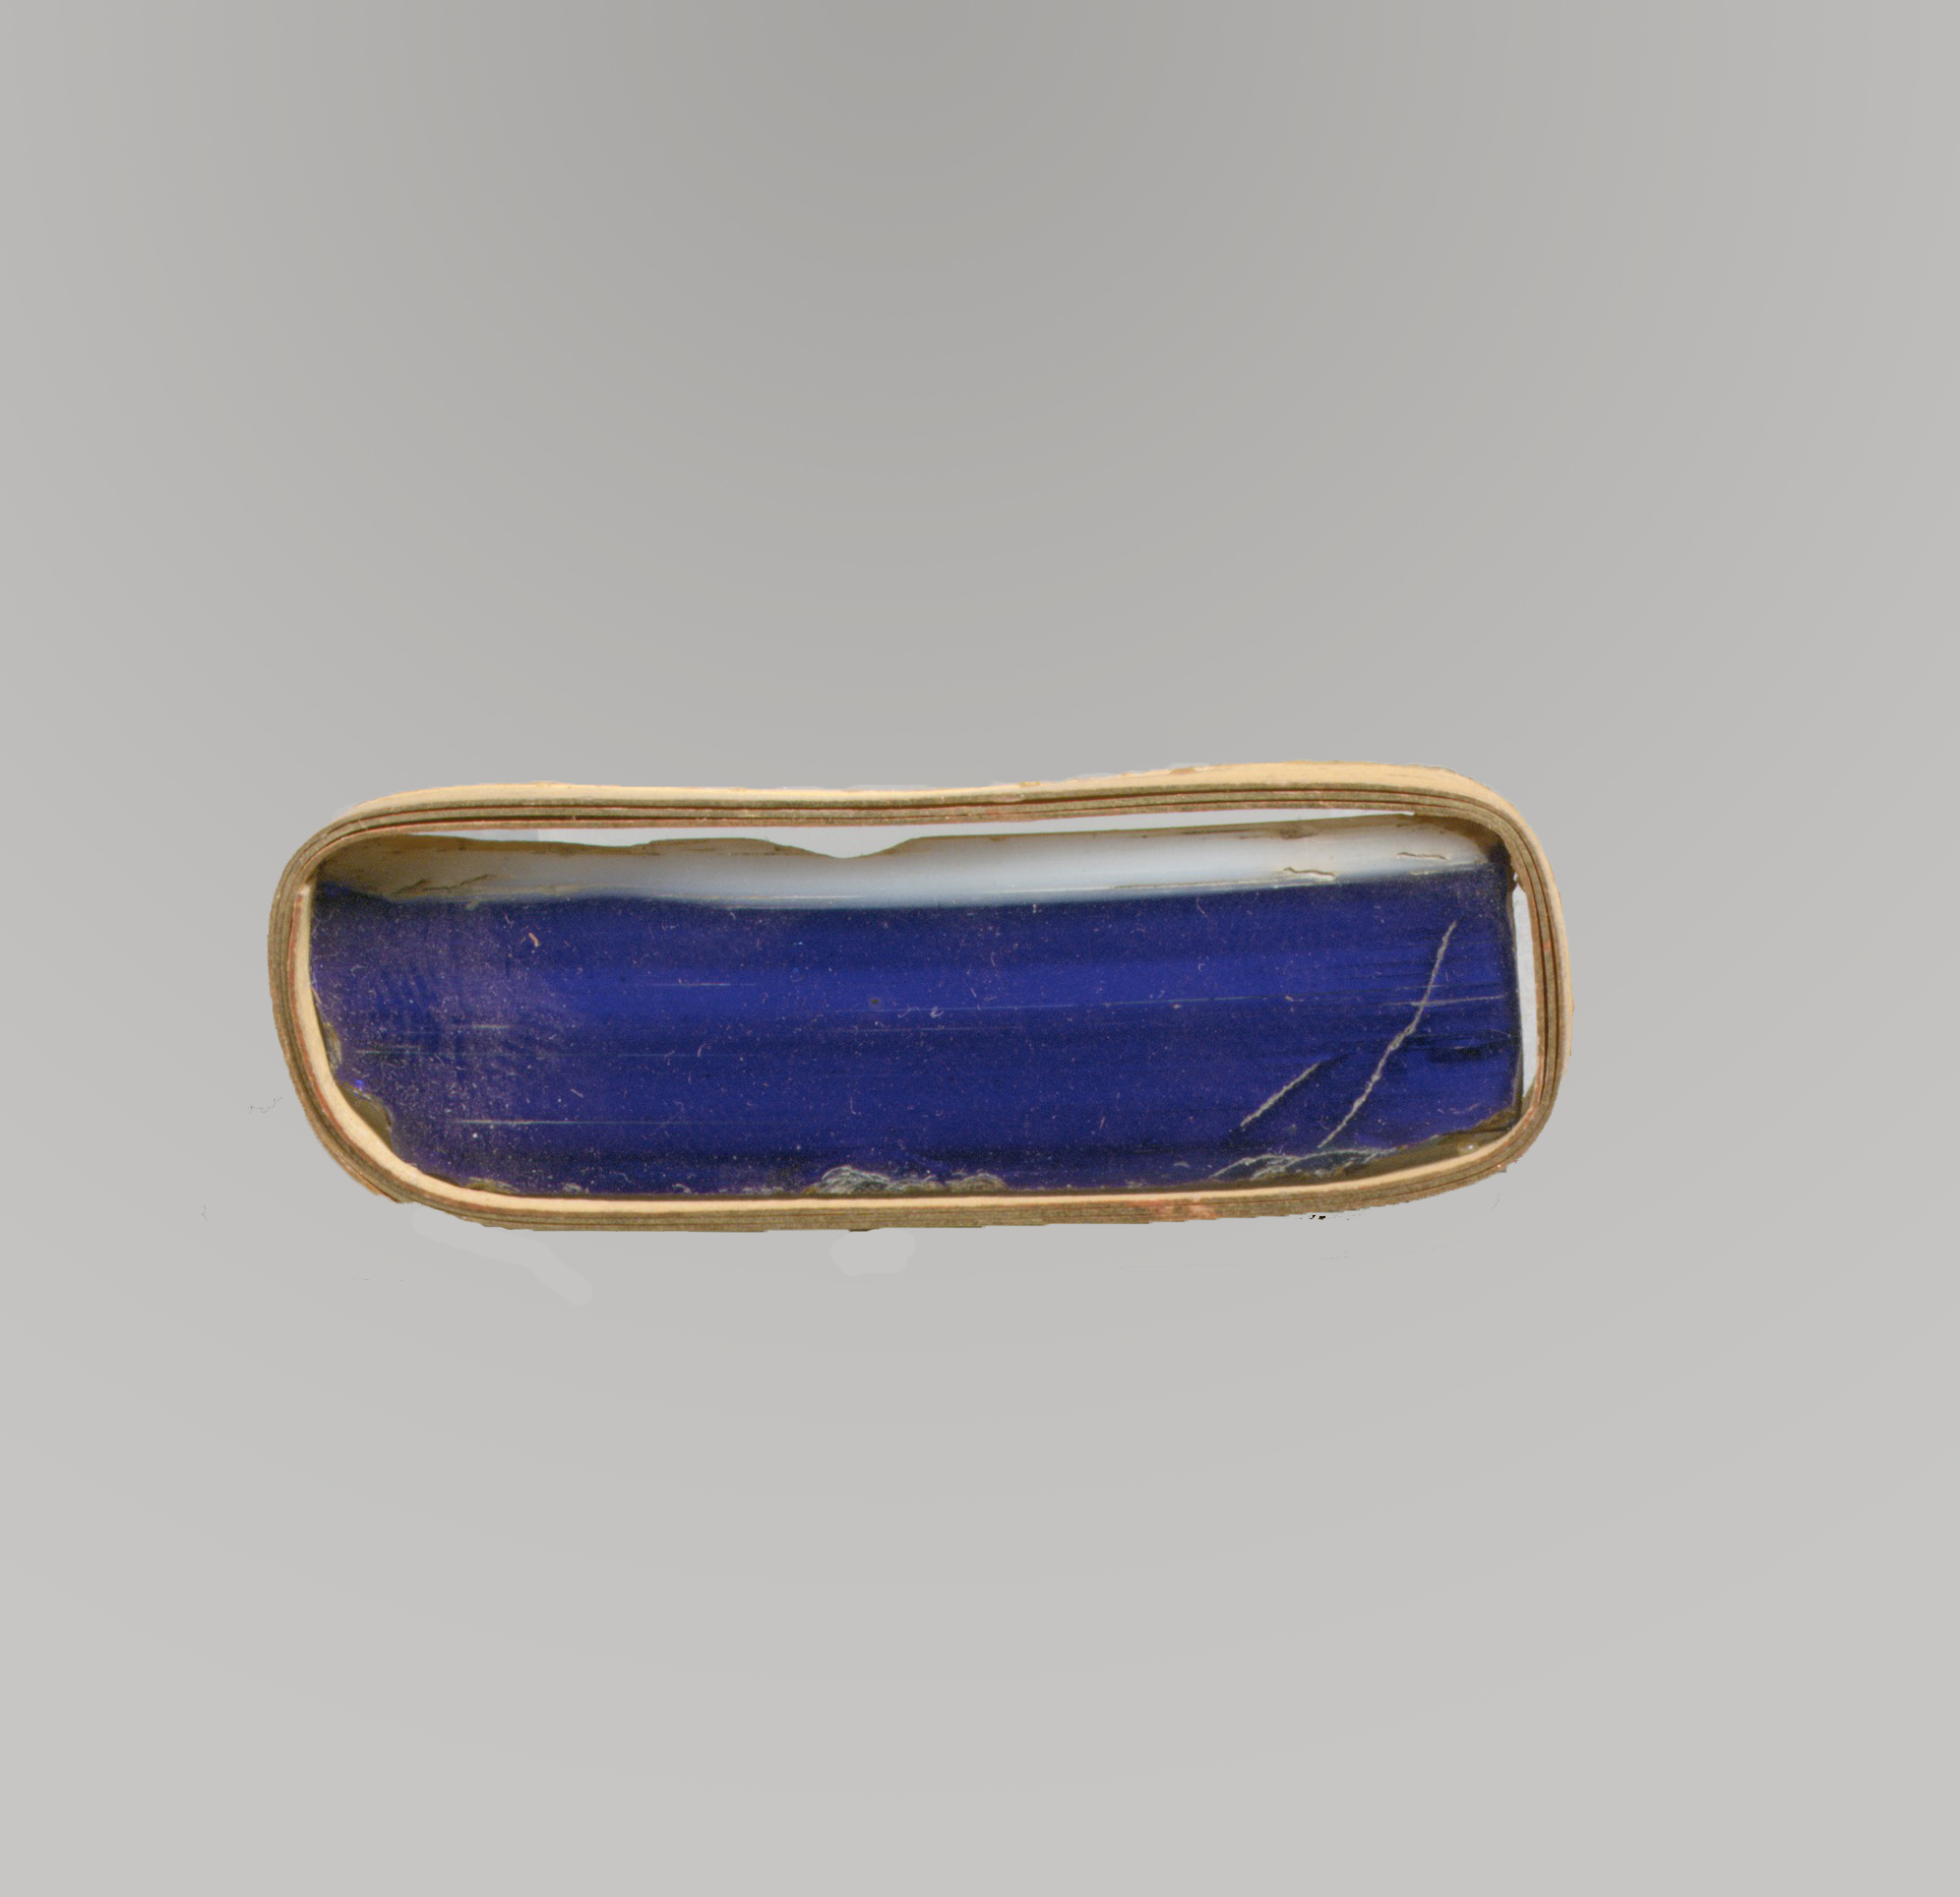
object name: fragment, inlay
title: Glass inlay fragment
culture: roman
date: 34 BCE-33 CE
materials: glass